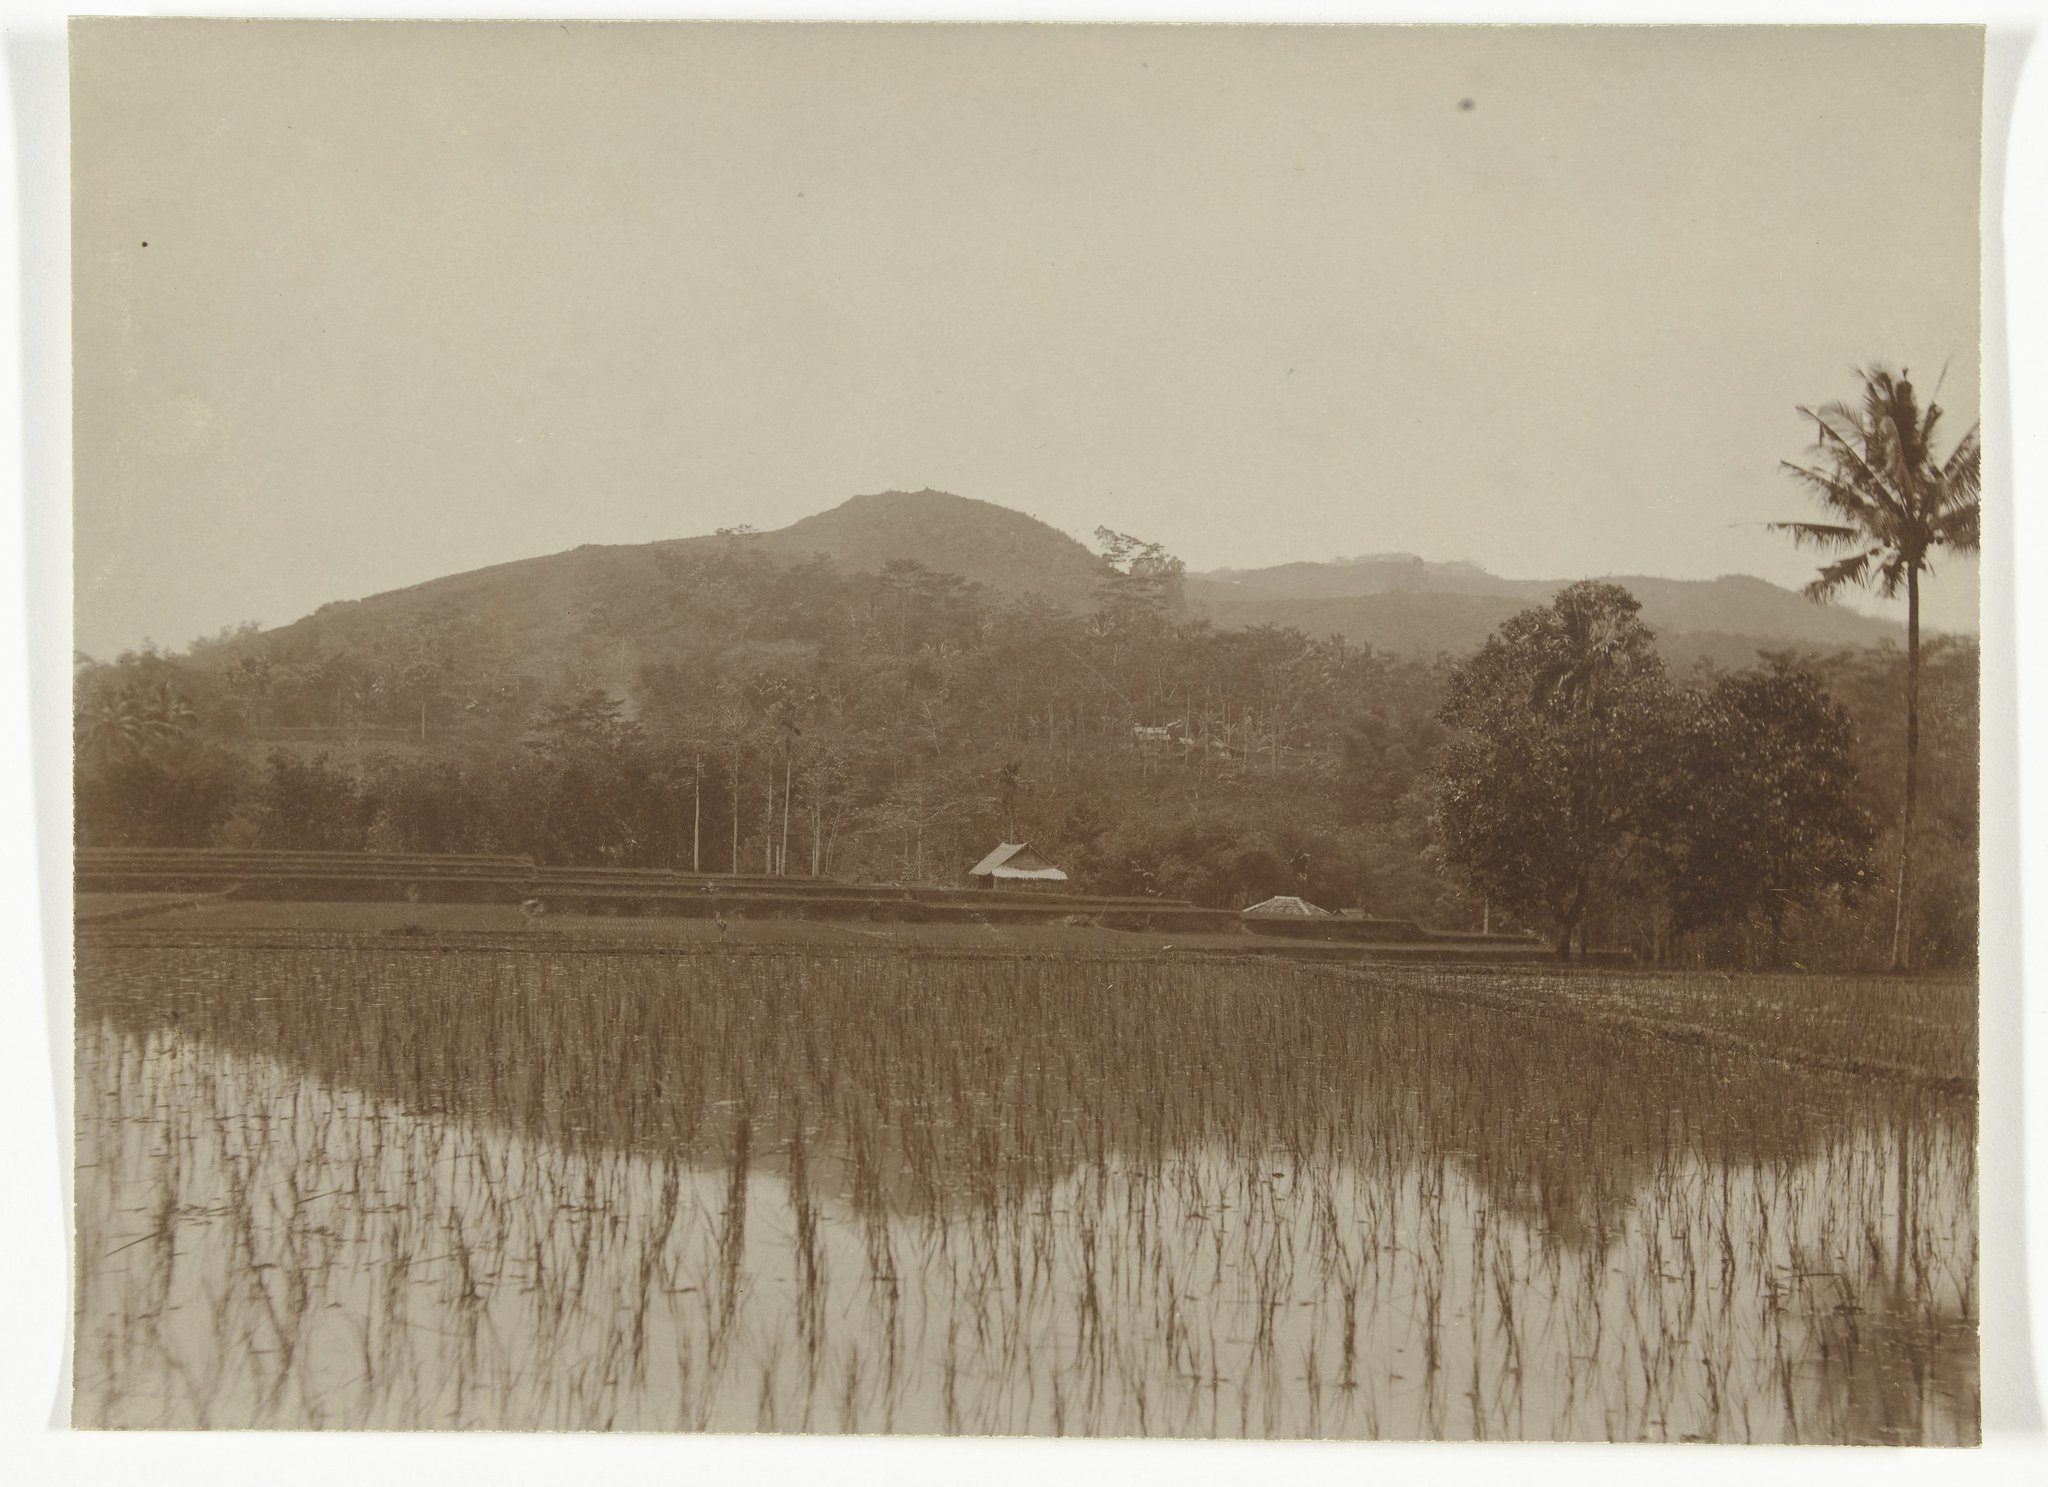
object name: photograph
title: Landschap met sawah, voormalig Nederlands-Indië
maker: onnes kurkdjian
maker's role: fotograaf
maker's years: 1851-1903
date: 1890-1911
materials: paper, photographic support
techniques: gelatin silver print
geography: dutch east indies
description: Landschap met sawah, voormalig Nederlands-Indië. Enkele huisjes aan de rand van de rijstvelden. Bergen op de achtergrond.